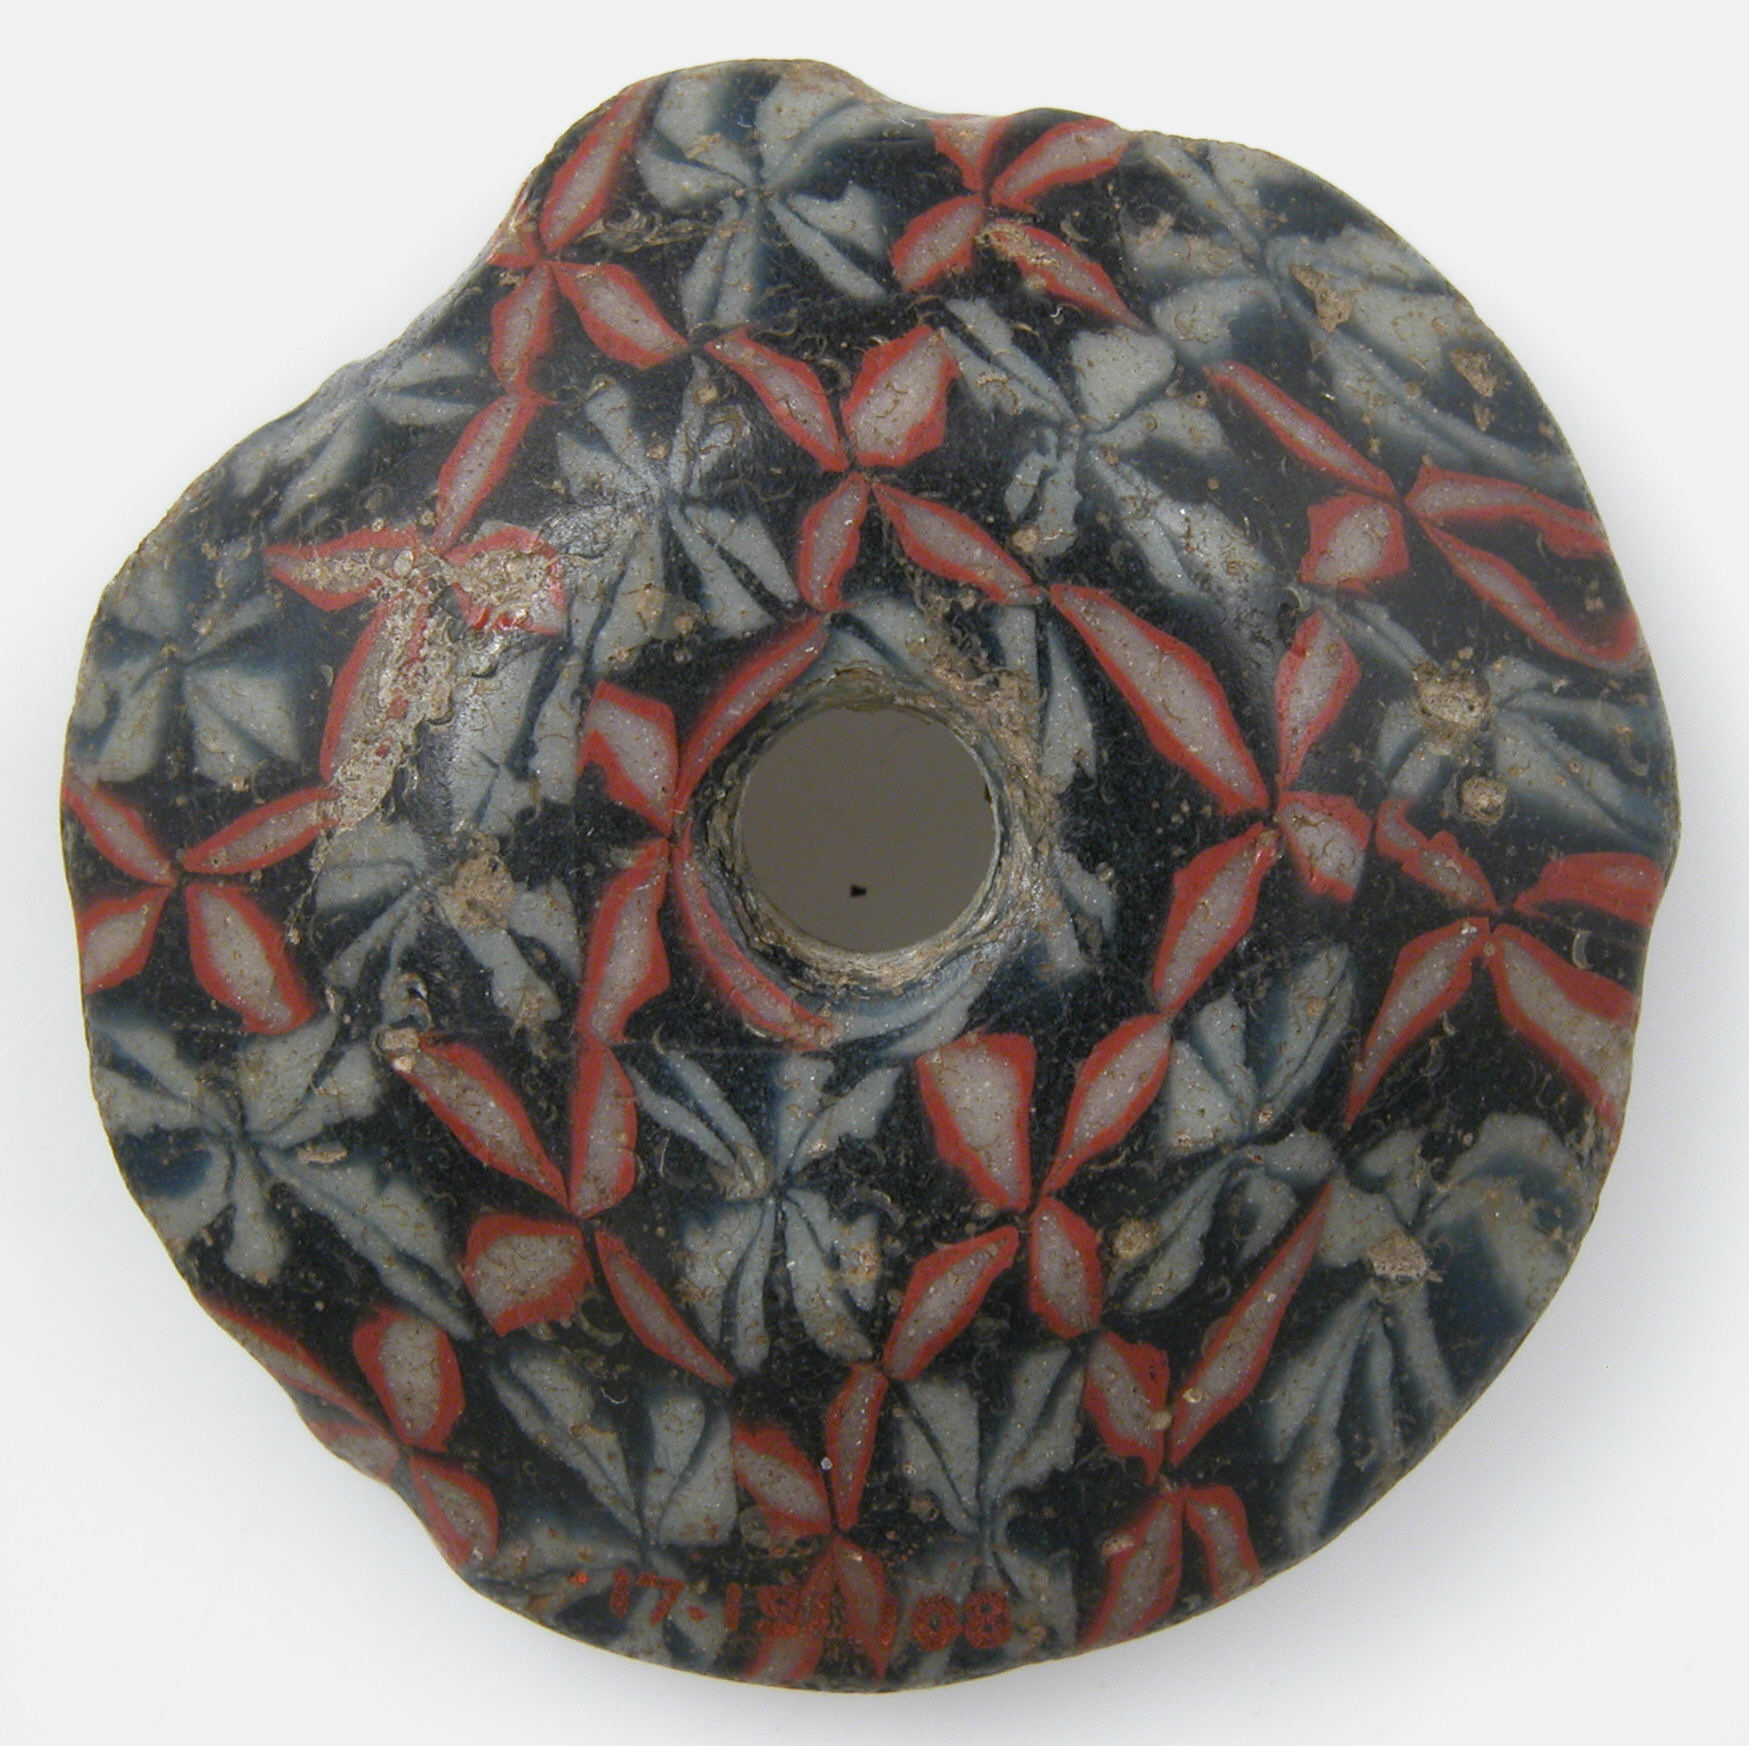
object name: bead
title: Conical Flattened Bead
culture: frankish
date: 500-600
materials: glass